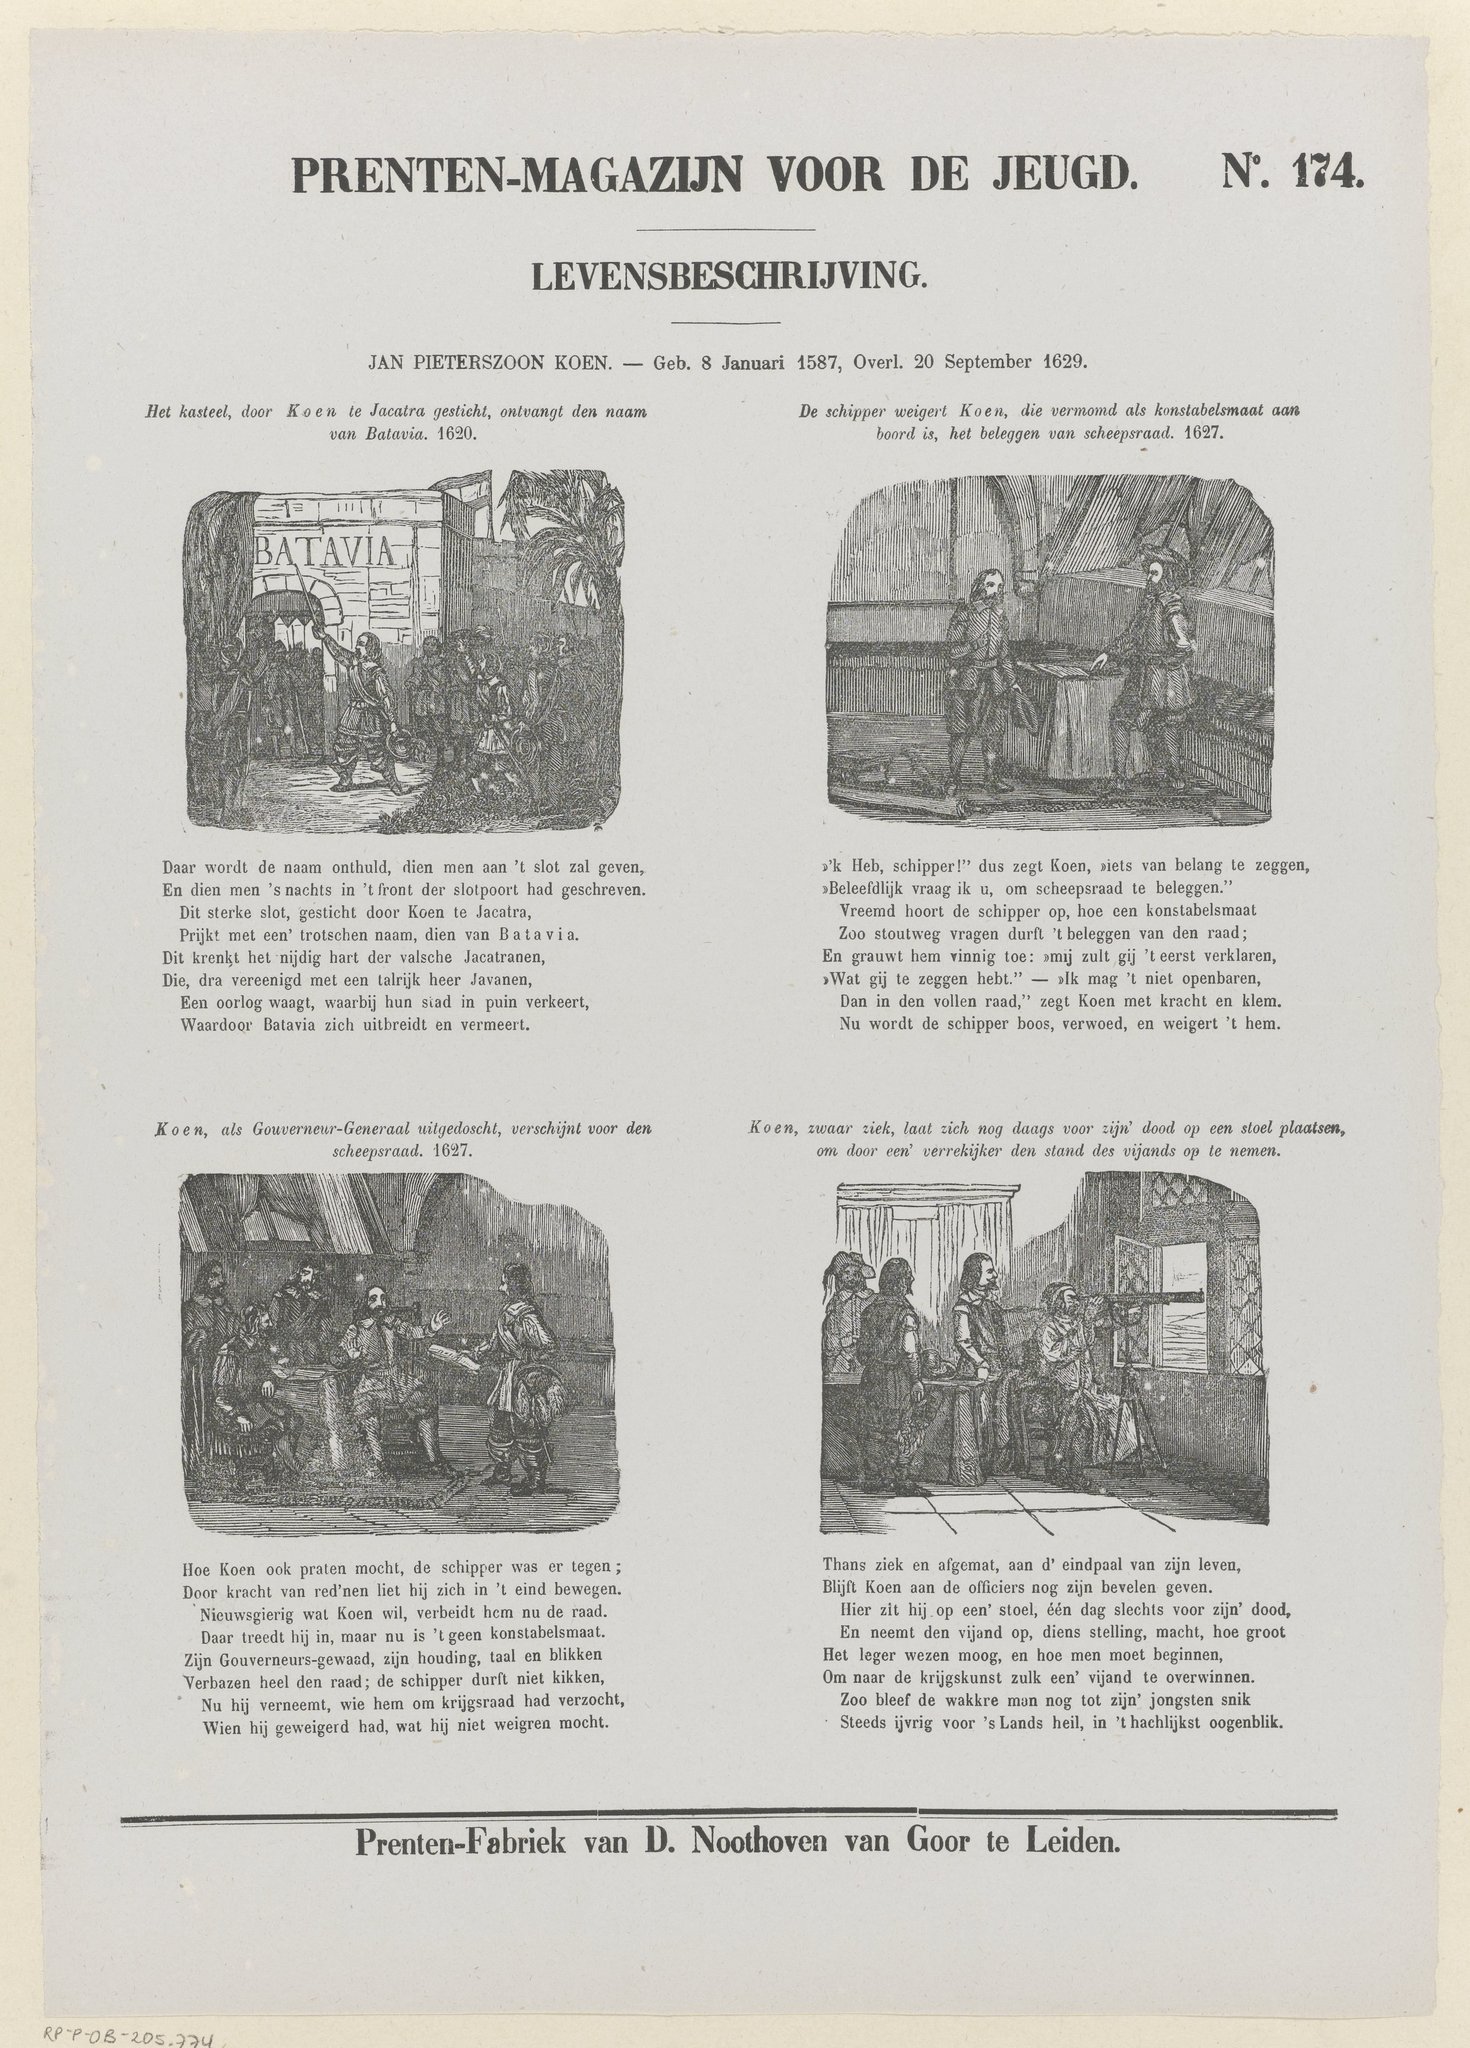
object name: print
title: Prenten-magazijn voor de jeugd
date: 1850-1881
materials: paper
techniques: letterpress printing, engraving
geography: leiden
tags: historical persons, batavia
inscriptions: collector's mark: Lugt 2760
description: Blad met 4 voorstellingen uit het leven van Jan Pietersz. Coen. Boven elke voorstelling een titel en onder elke voorstelling een achtregelig vers. Genummerd rechtsboven: No. 174.